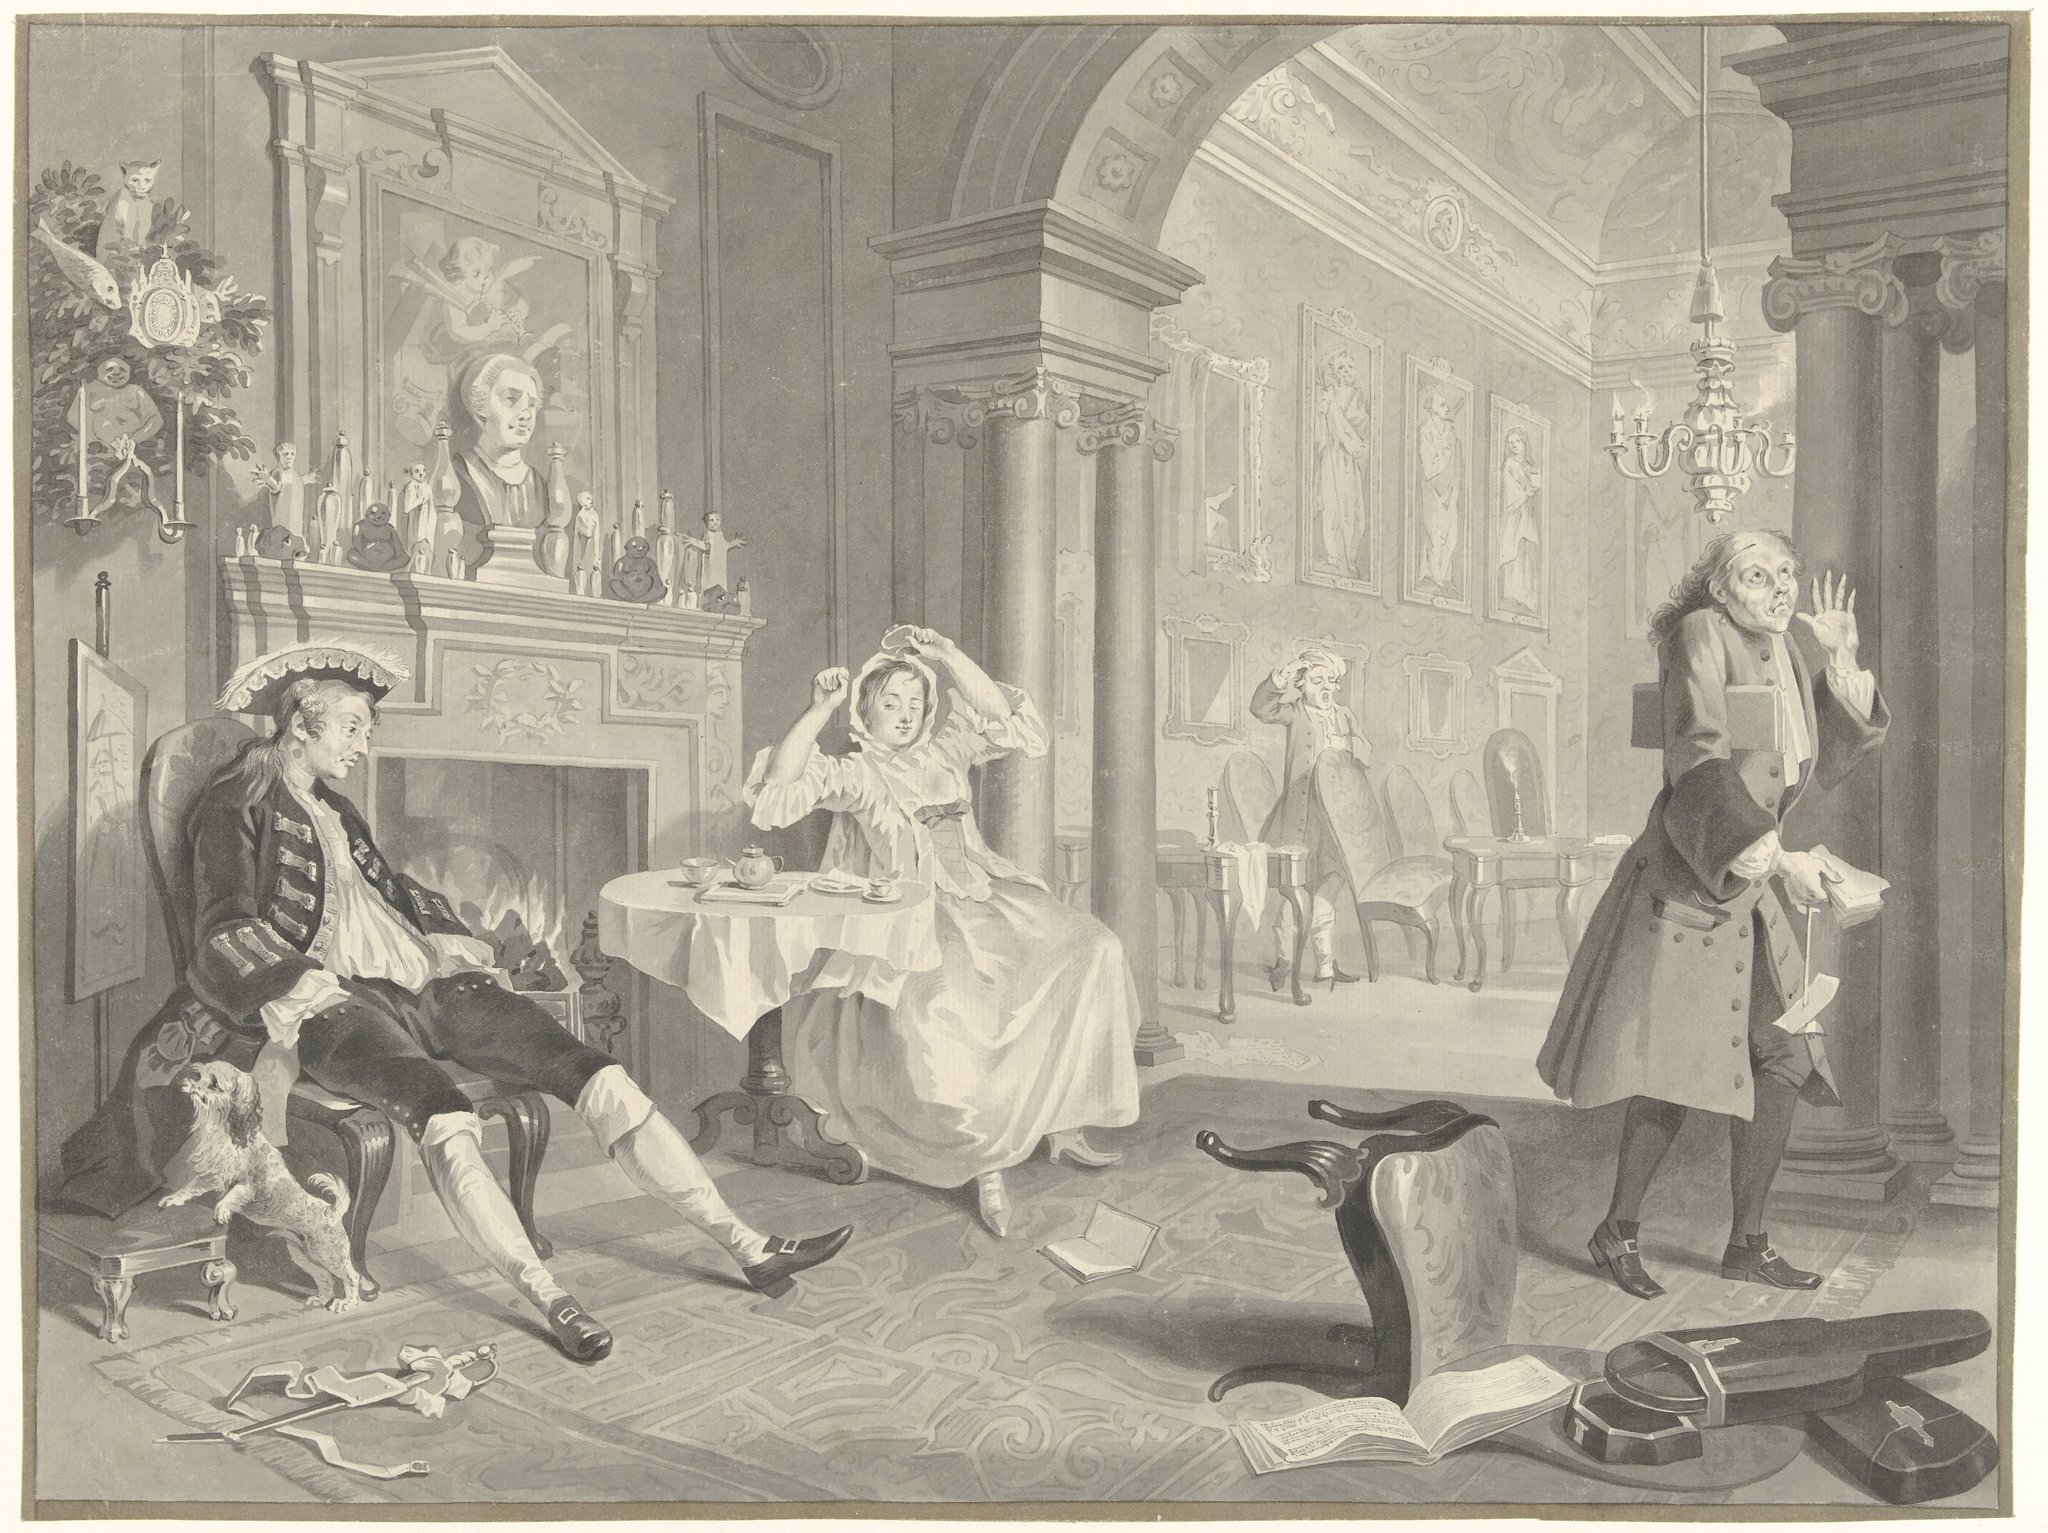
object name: drawing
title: In de aanvang van 't slechte huyshouwen der Jonge luyden (...)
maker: cornelis ploos van amstel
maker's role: draughtsman, print maker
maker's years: 1726-1798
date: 1748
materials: ink, paper, pencil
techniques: brush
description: Blad 2 uit een serie van 6 bladen. Met apart opgezet en gedateerd inhoudsblad (volgens JWN in ander handschrift dan dat van Ploos van Amstel).